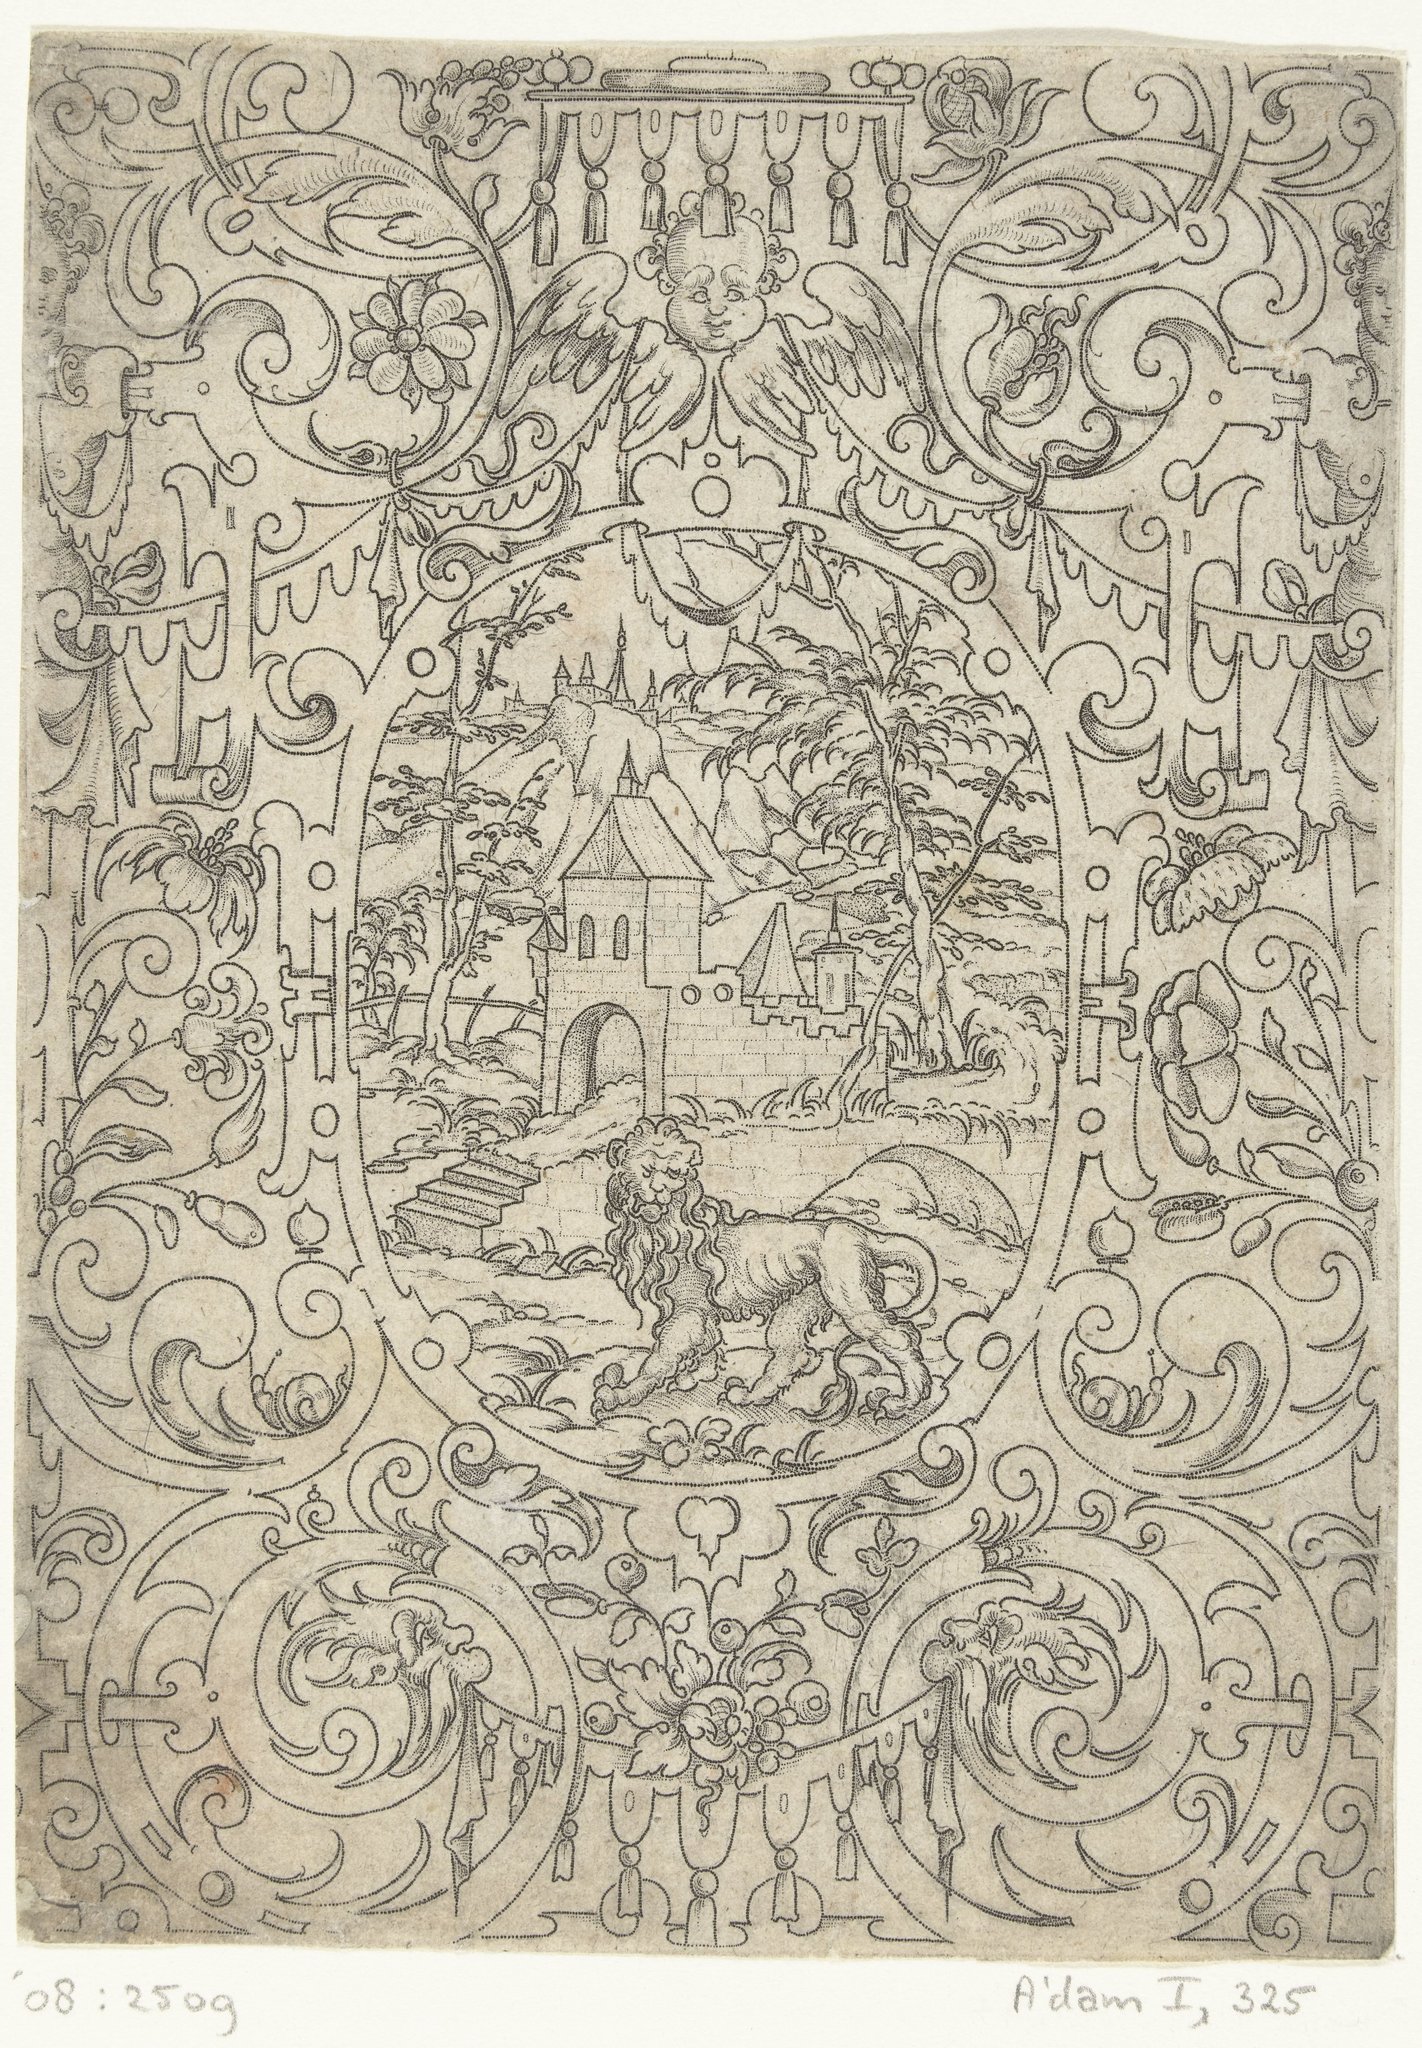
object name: print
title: Landschap met een leeuw in een ovaal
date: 1592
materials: paper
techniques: engraving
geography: germany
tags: beasts of prey, predatory animals: lion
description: Vlakdecoratie. Ovaal met een landschap, omlijst door krulwerk met bloemen, een cherubijntje (middenboven) en mascarons (linksonder en rechtsonder). Blad uit een serie bestaande uit een titelblad en 7 bladen.